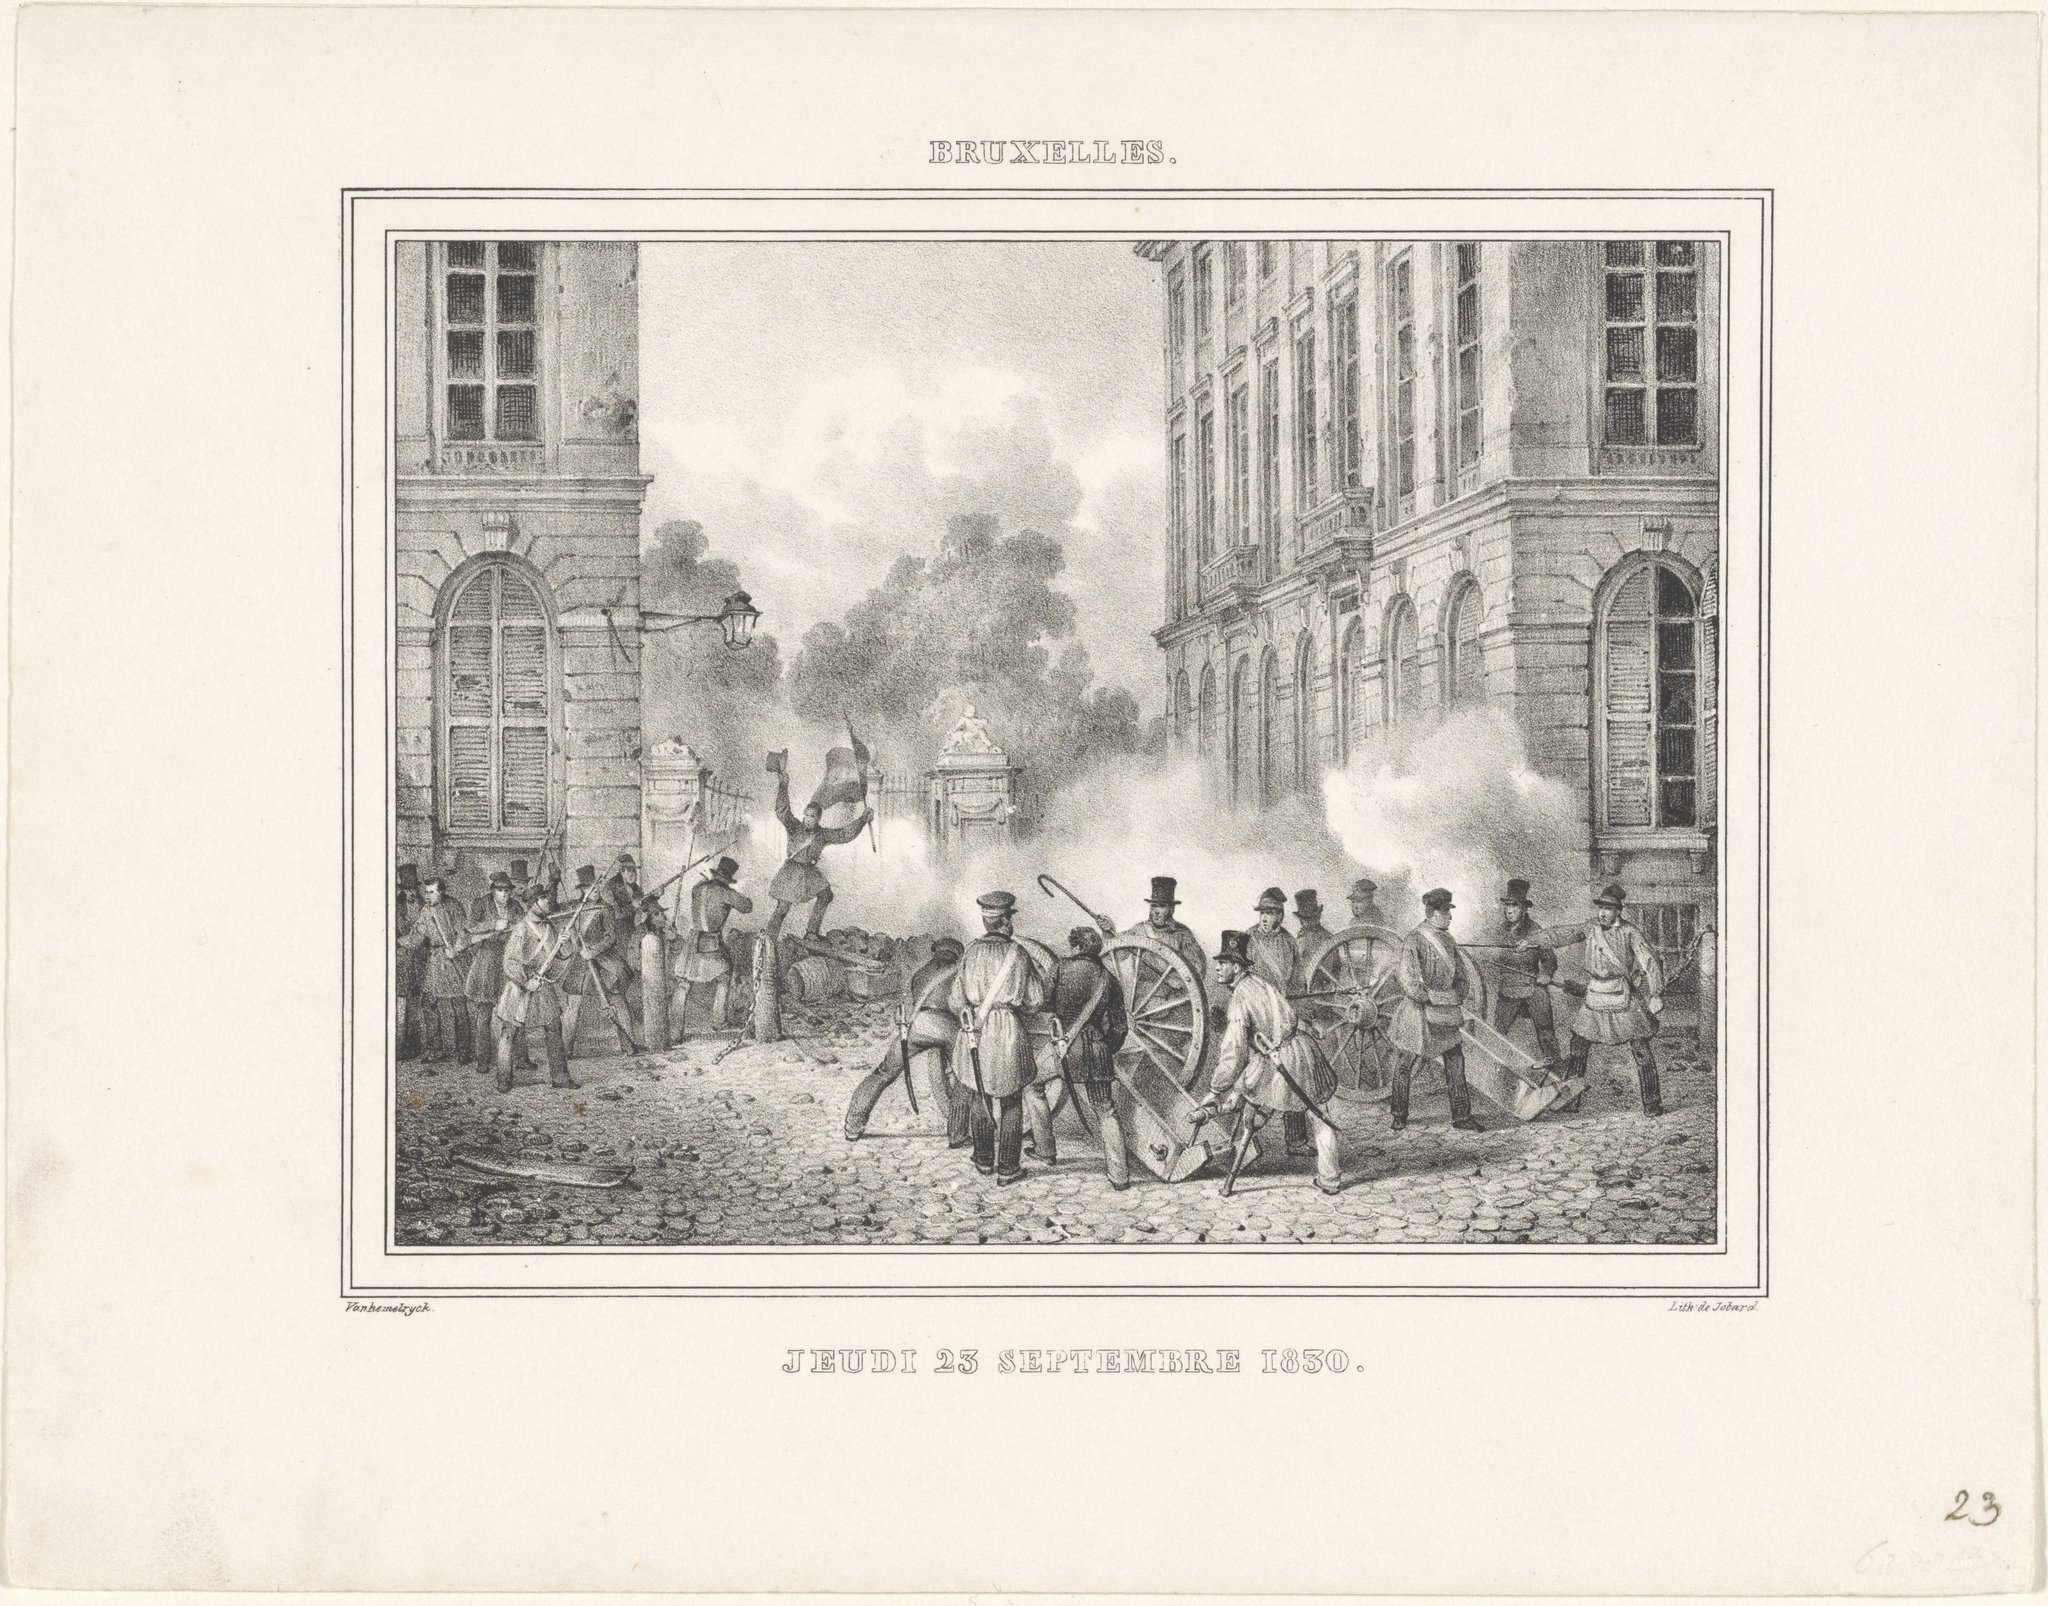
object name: print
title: Gevechten bij het park in Brussel, 1830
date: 1830-1831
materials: paper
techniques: lithograph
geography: brussels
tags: barricades ~ riot, brussels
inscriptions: collector's mark: Lugt 2228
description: Belgische opstandelingen achter een barricade bij het Warandepark te Brussel op 23 september 1830. Achter één kanonnen staat Jambe de Bois. Onderdeel van een groep van prenten uit verschillende andere series verwant aan de platen in het recueil over de gebeurtenissen tijdens de Belgische Revolutie in Brussel, Antwerpen en andere steden in de periode 25 augustus 1830 tot 27 maart 1831.